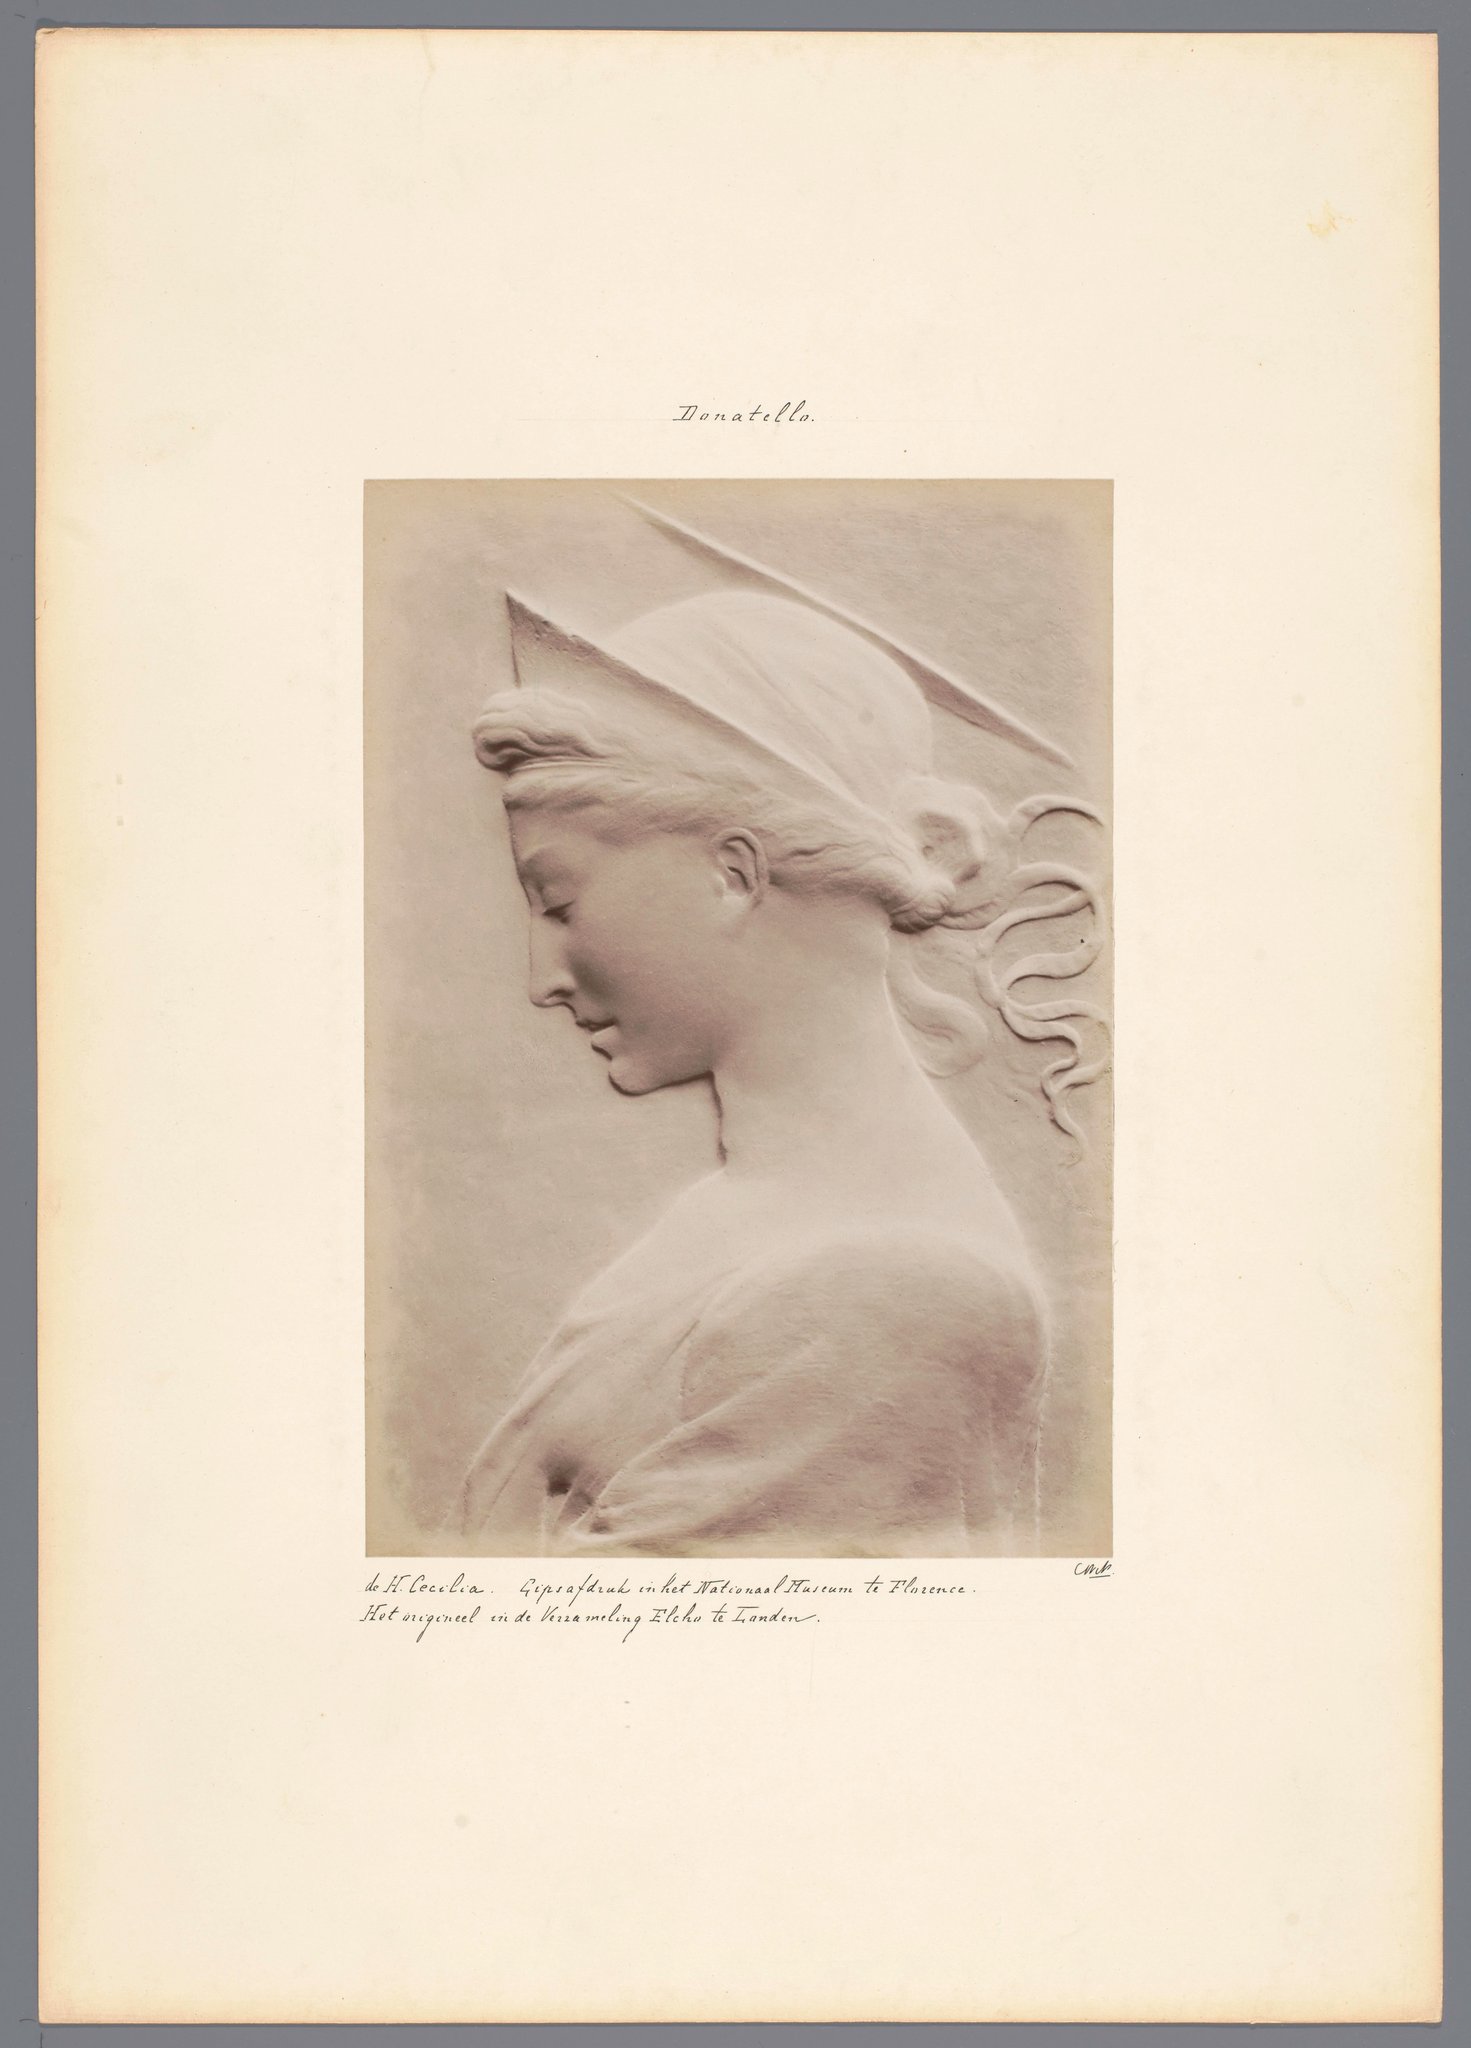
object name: photograph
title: Donatello. de H. Cecilia . Gipsafdruk in het Nation Museum te Florence.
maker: Anonymous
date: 1875-1900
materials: cardboard, photographic support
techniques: albumen print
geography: florence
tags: the virgin martyr cecilia of rome; possible attributes: falcon, musical instruments, organ, wreath of roses and lilies, piece of sculpture, reproduction of a piece of sculpture (+ sculpture)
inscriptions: collector's mark: ‘KUNSTNIJVERHEIDSCHOOL QUELLINUS AMSTERDAM FRANS HALSSTRAAT 14.’, collector's mark: ‘INSTITUUT VOOR KUNST-NIJVERHEIDSONDERWIJS GABRIËL METSUSTRAAT No. 16 AMSTERDAM’, inscription: ‘CWN.’